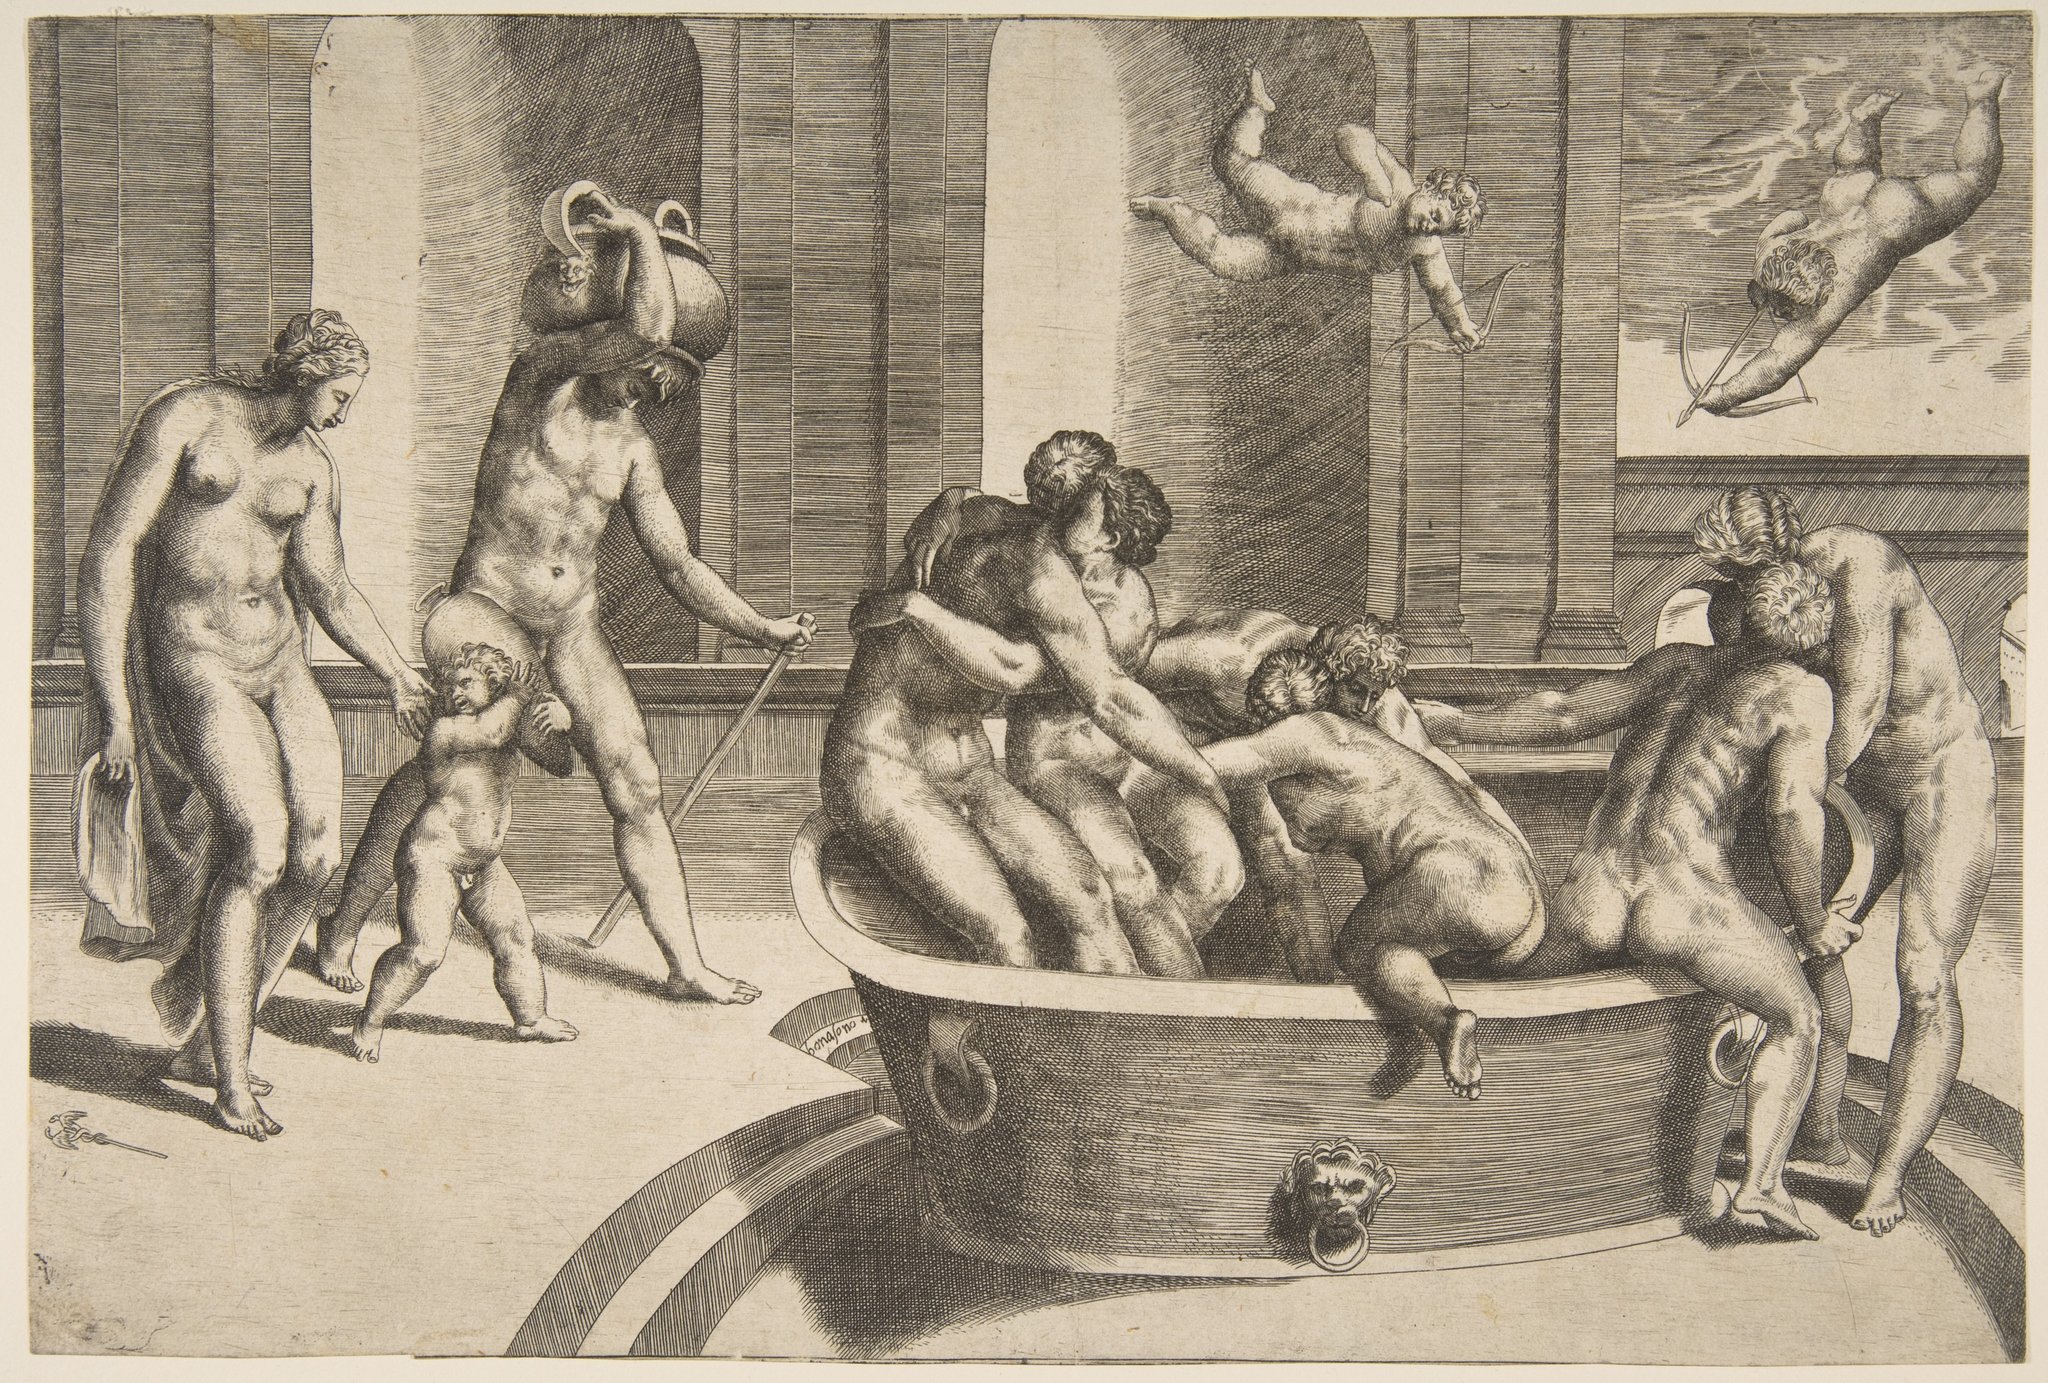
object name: print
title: Men and women bathing, some embracing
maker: giulio bonasone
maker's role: artist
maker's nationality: italian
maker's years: 1510-1576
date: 1531-1576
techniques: engraving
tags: male nudes,female nudes,mythical creatures,bathing